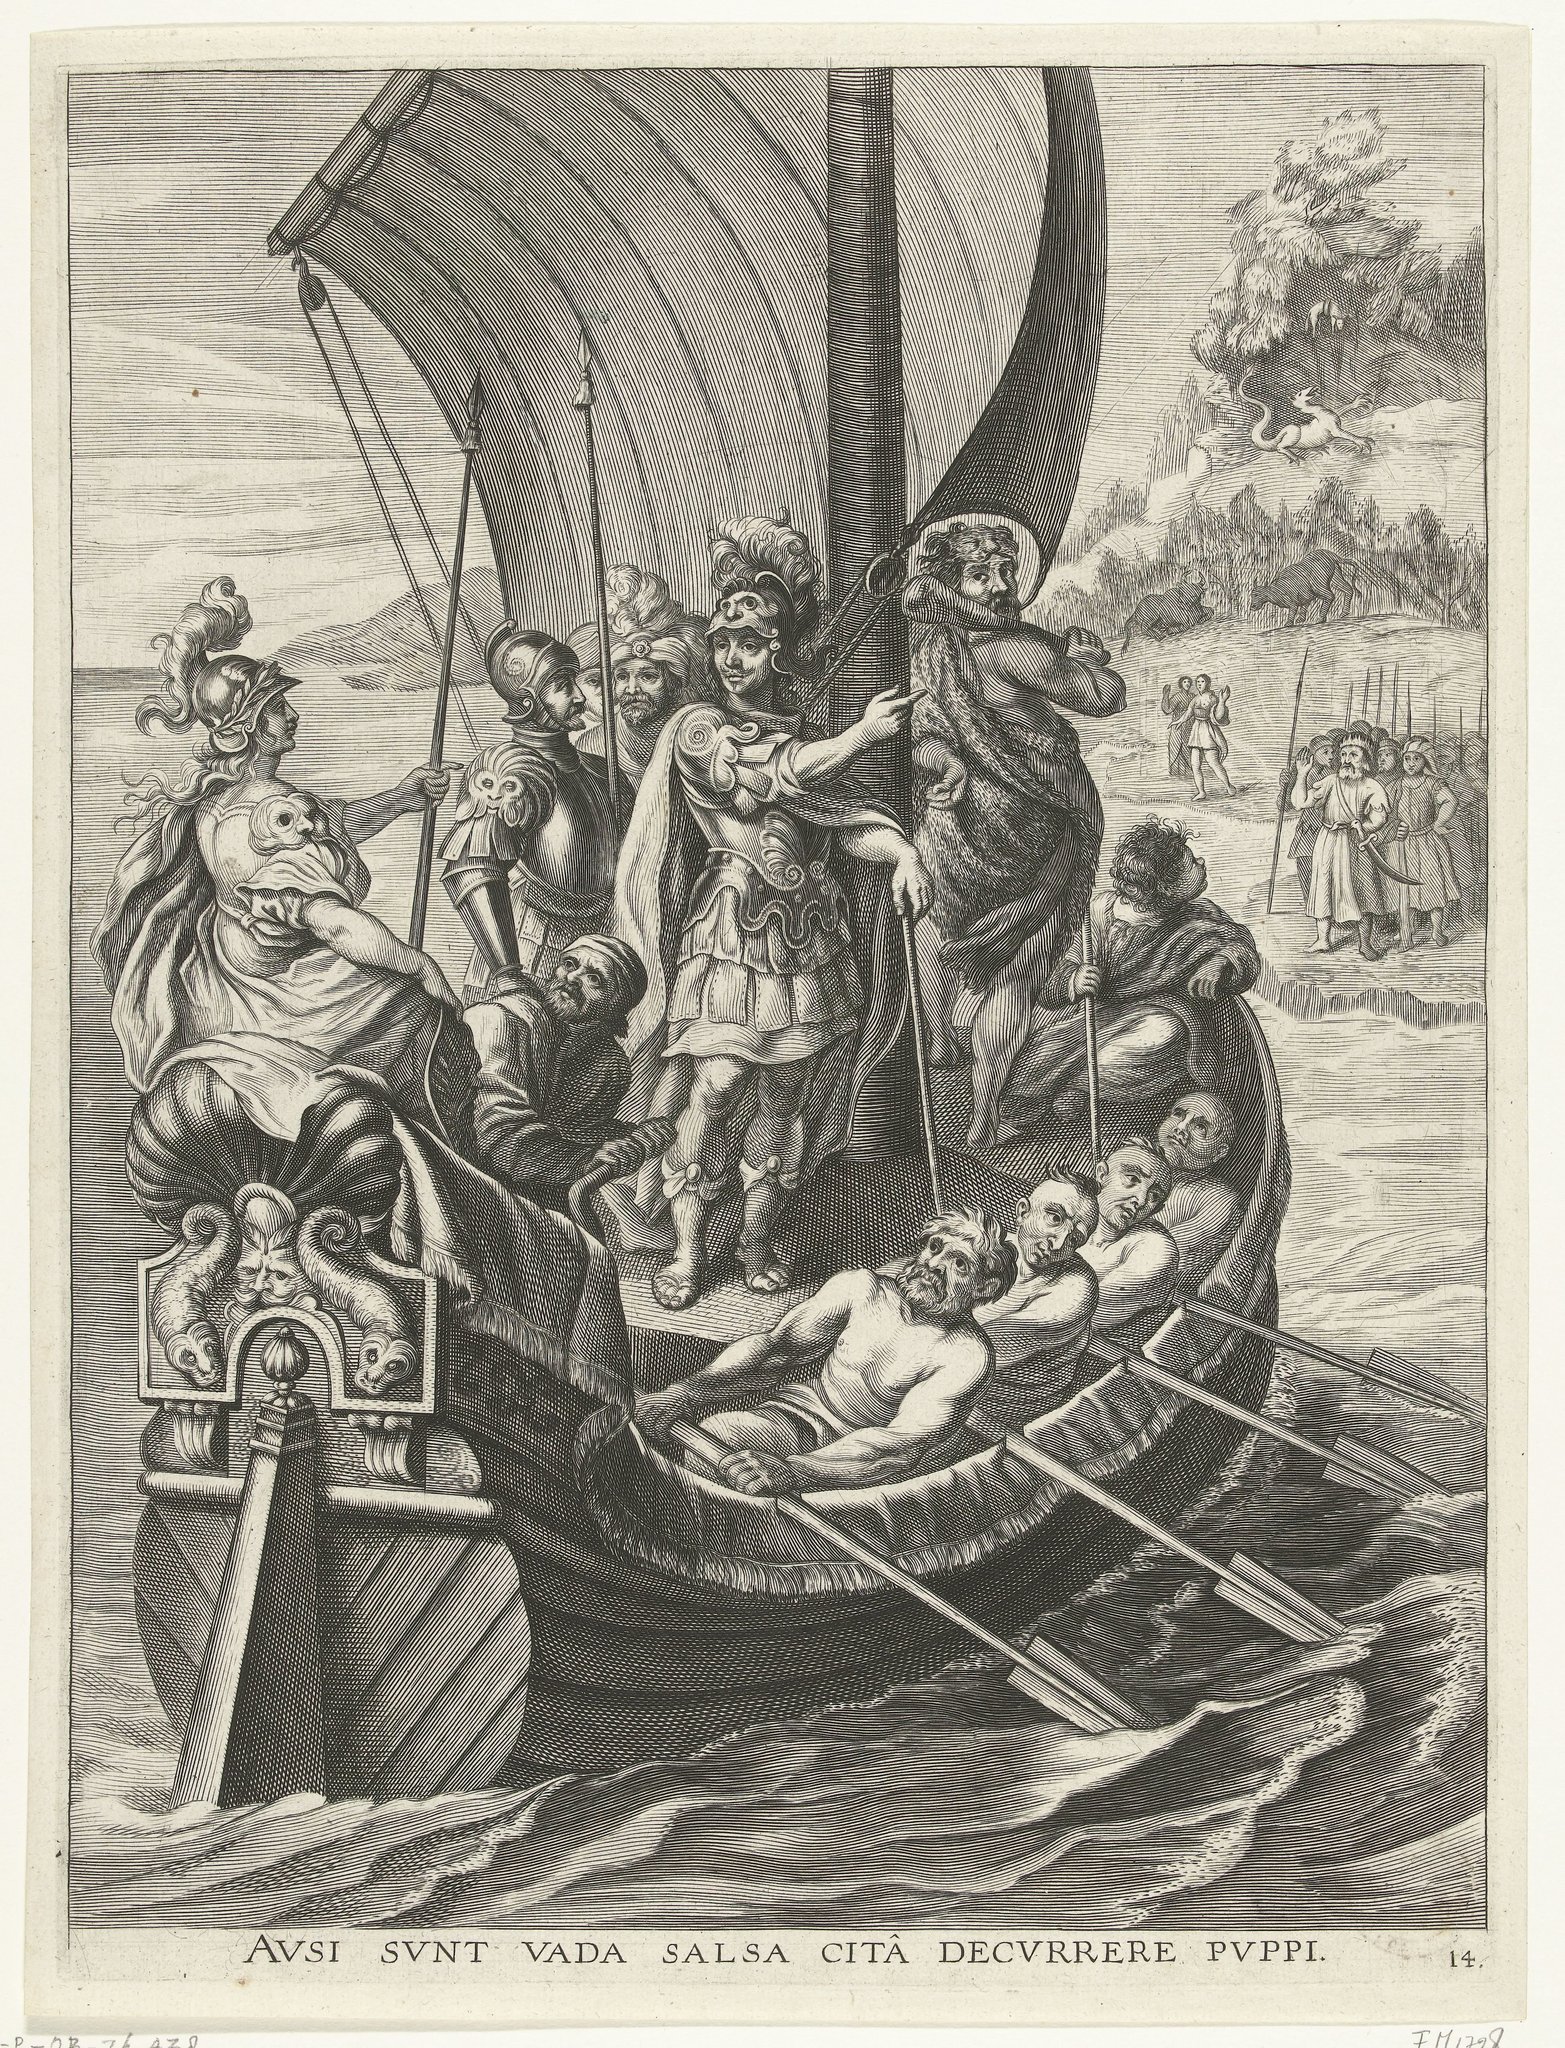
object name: print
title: Tabula II. Argonautae cum Ferdinando navigante collati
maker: jacobus van schoor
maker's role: print maker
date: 1635-1636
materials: paper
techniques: engraving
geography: southern netherlands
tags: brussels, landvoogd der zuidelijke nederlanden ferdinand van oostenrijk, the argonauts in colchis, triumphal arch, ghent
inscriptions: collector's mark: Lugt 240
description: Ferdinand van Oostenrijk zeilt mee op het schip met Jason en de Argonauten. Voorstelling rechtsboven op de achterzijde van de triomfpoort Arcus Fernandi op de Vrijdagmarkt. Blad nr. 14 in een geheel van 42 platen die de uitgave van de beschrijving van de intocht van de Kardinaal Infant Ferdinand van Oostenrijk te Gent op 28 januari 1635 als de nieuwe landvoogd voor de Spaanse Nederlanden illustreren.